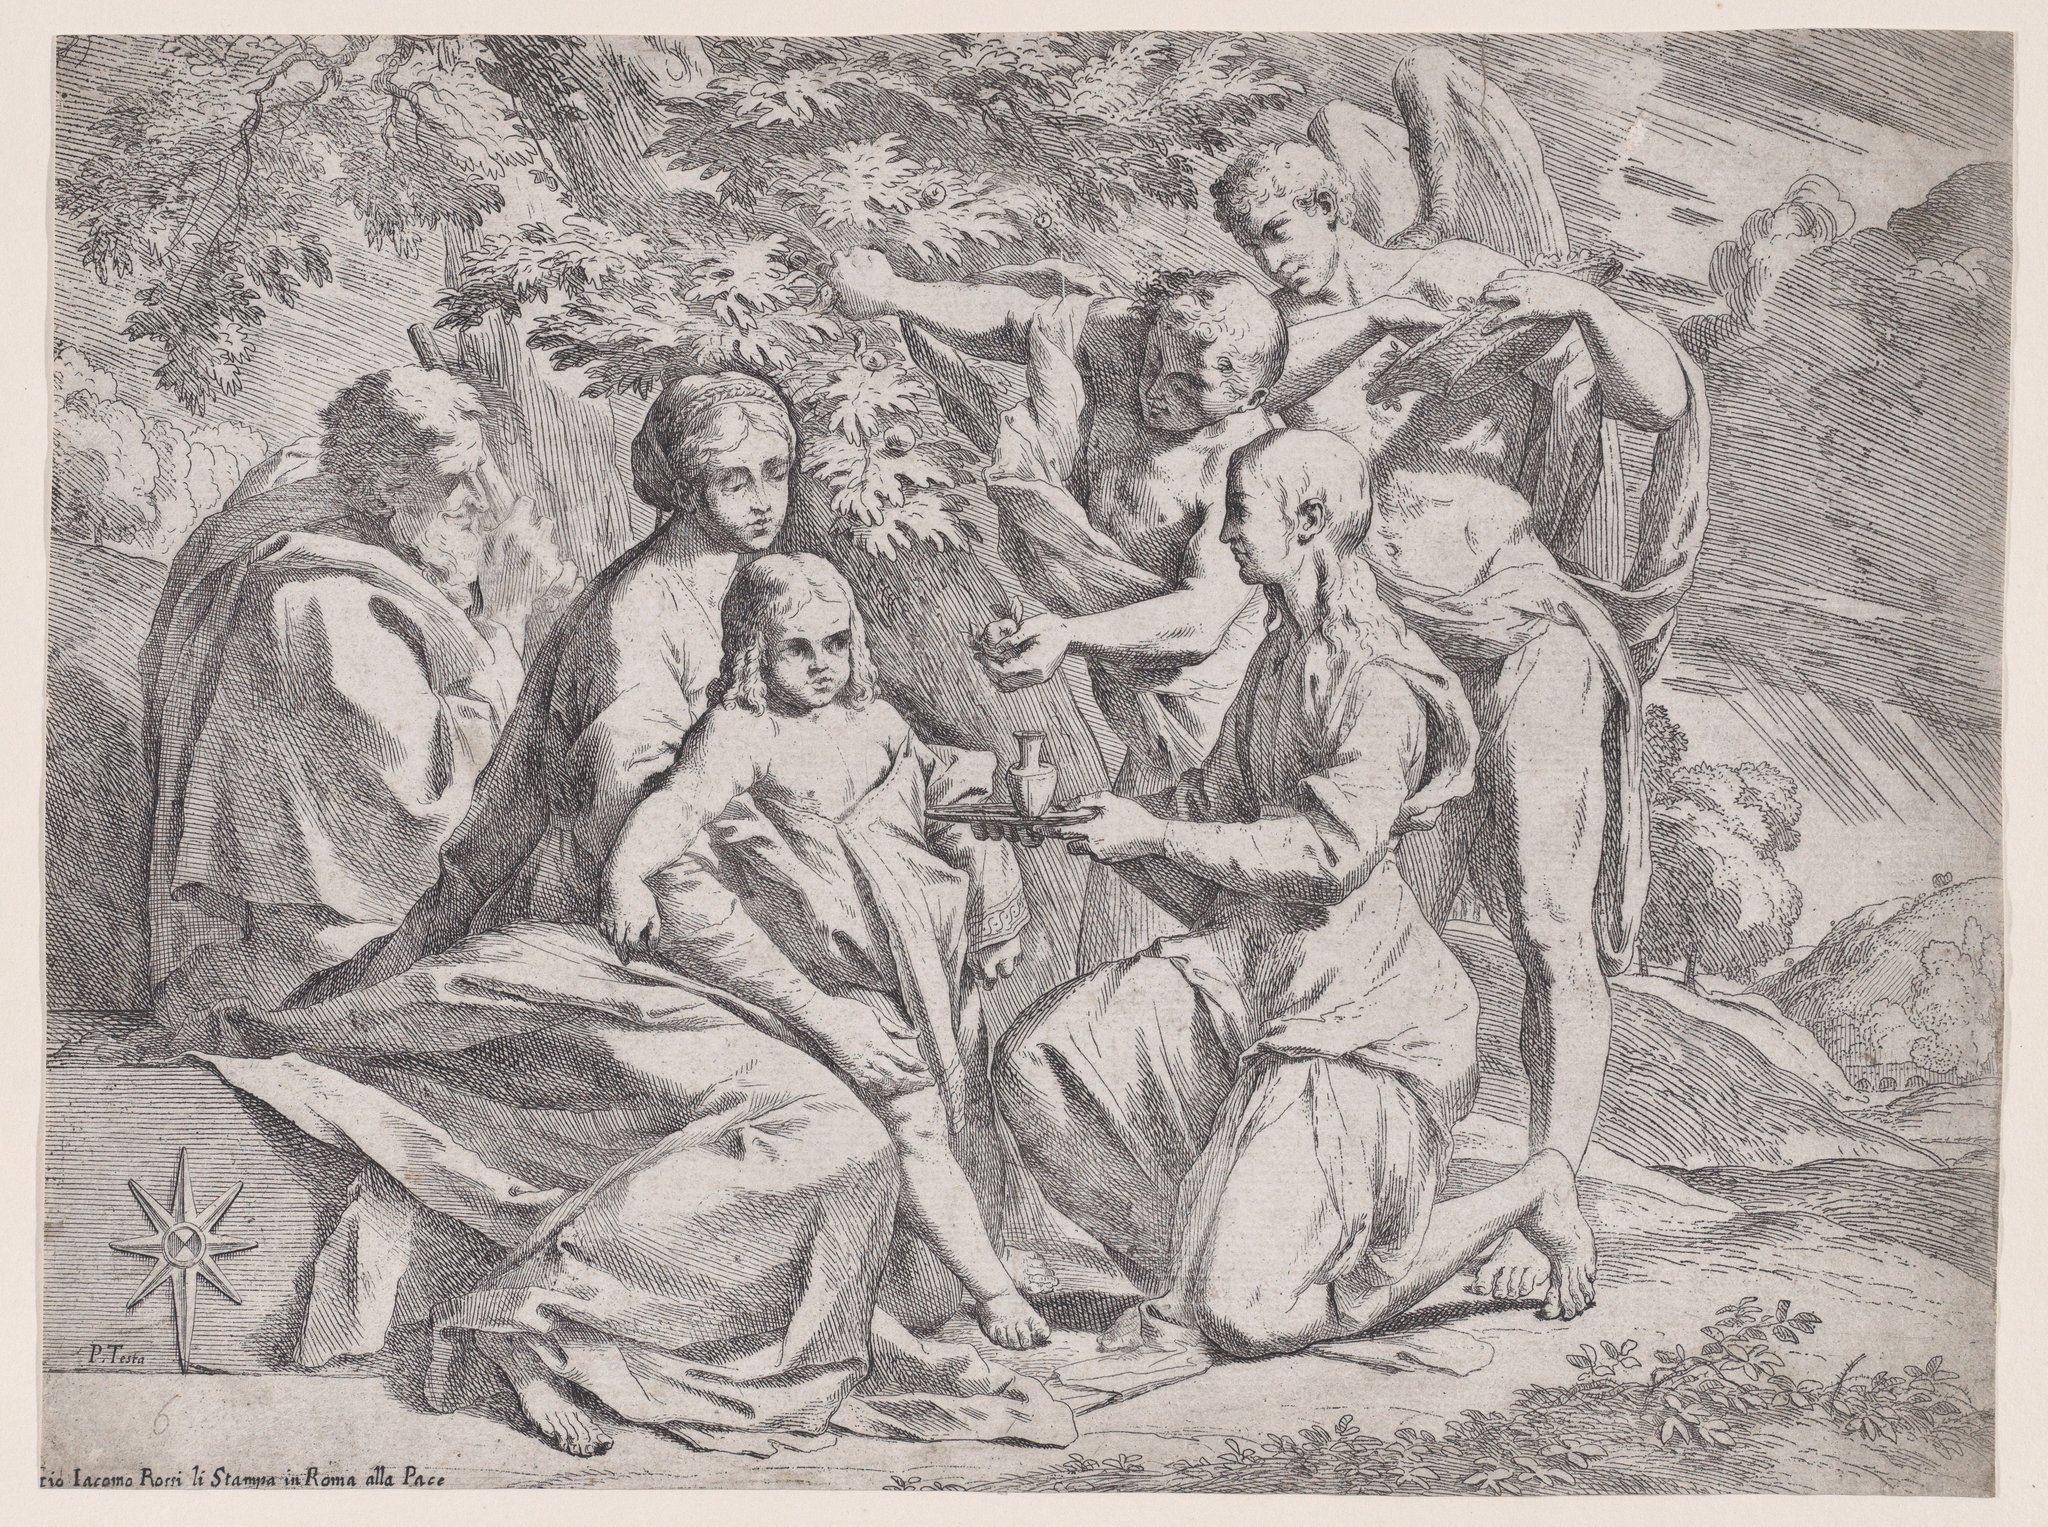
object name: print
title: The Holy Family attended by Angels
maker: pietro testa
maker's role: artist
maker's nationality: italian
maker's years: 1612-1650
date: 1642-1644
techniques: etching